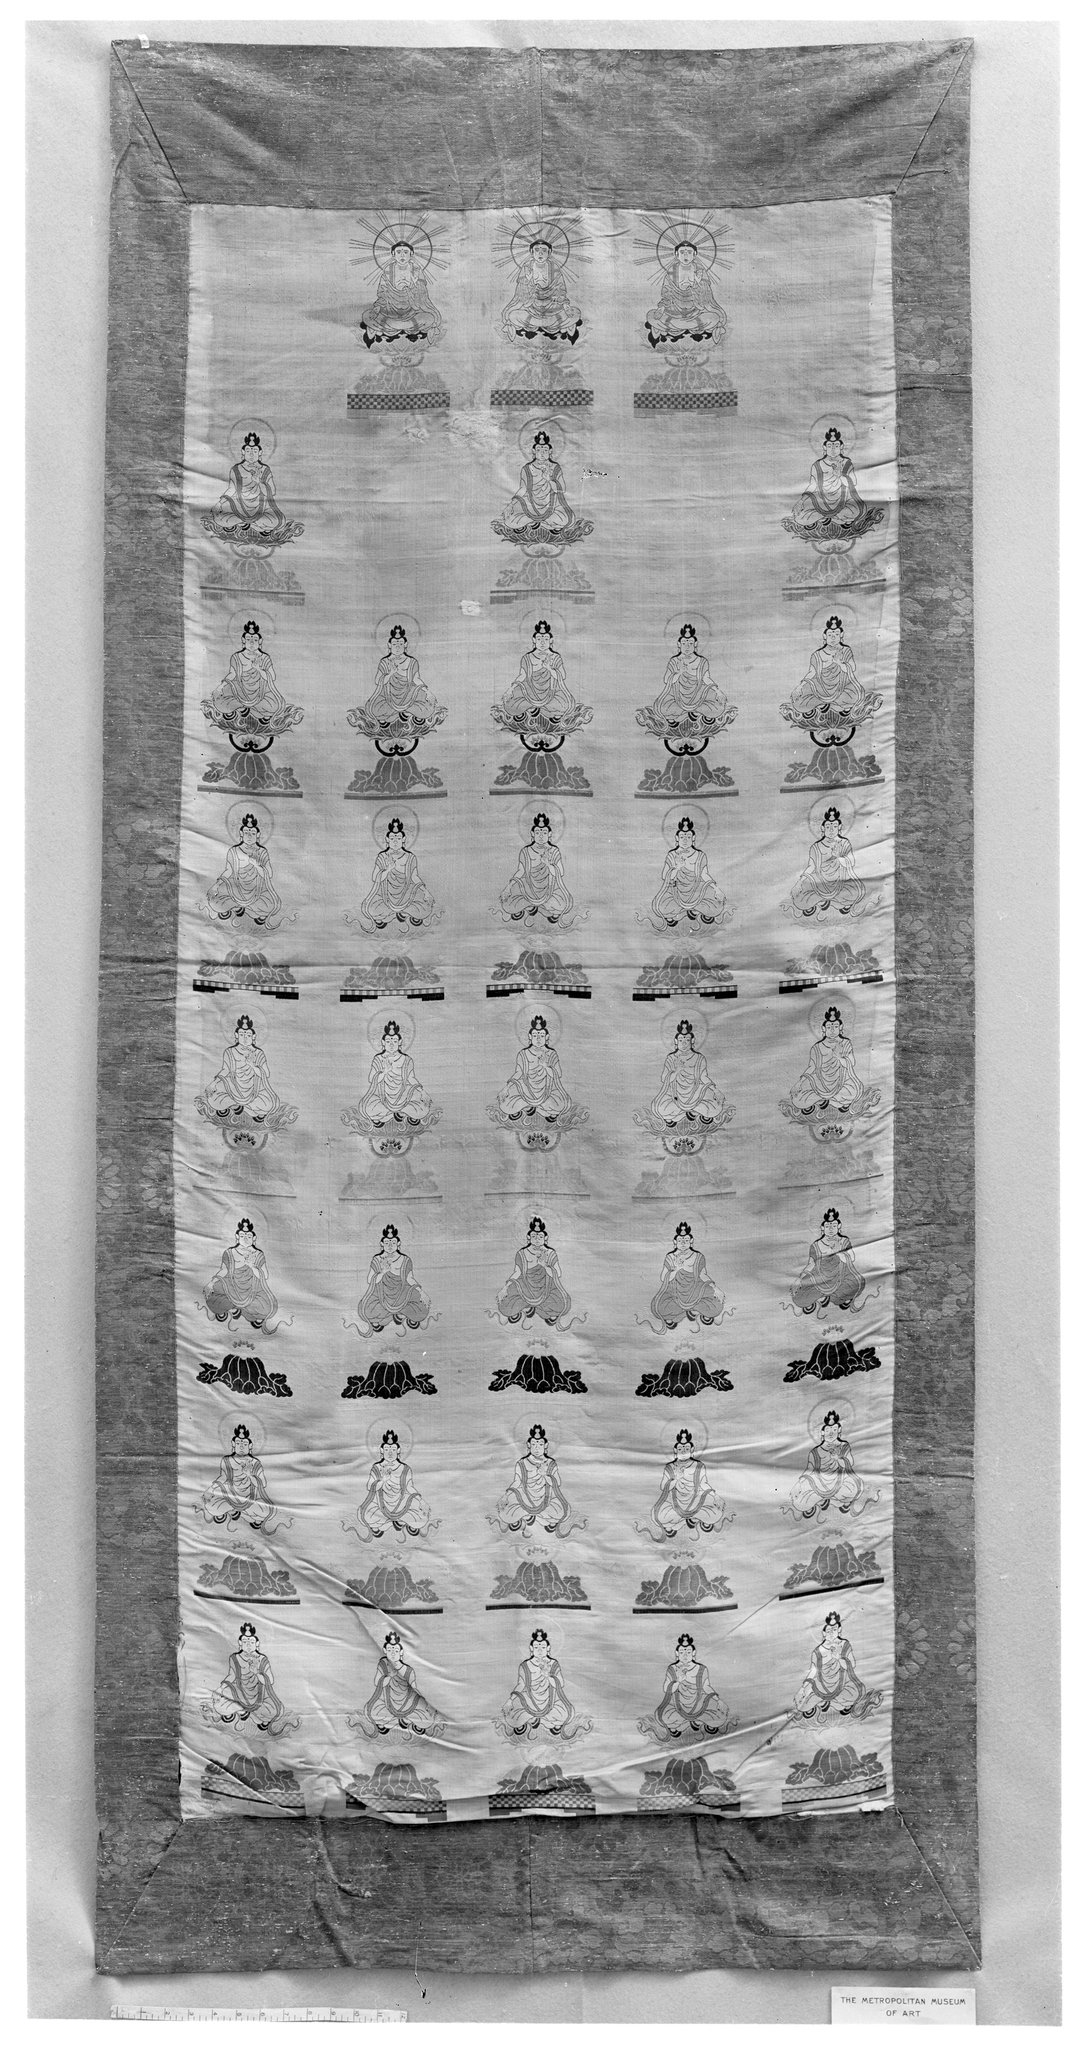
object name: altar cloth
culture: japanese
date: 1801-1900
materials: silk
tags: buddha